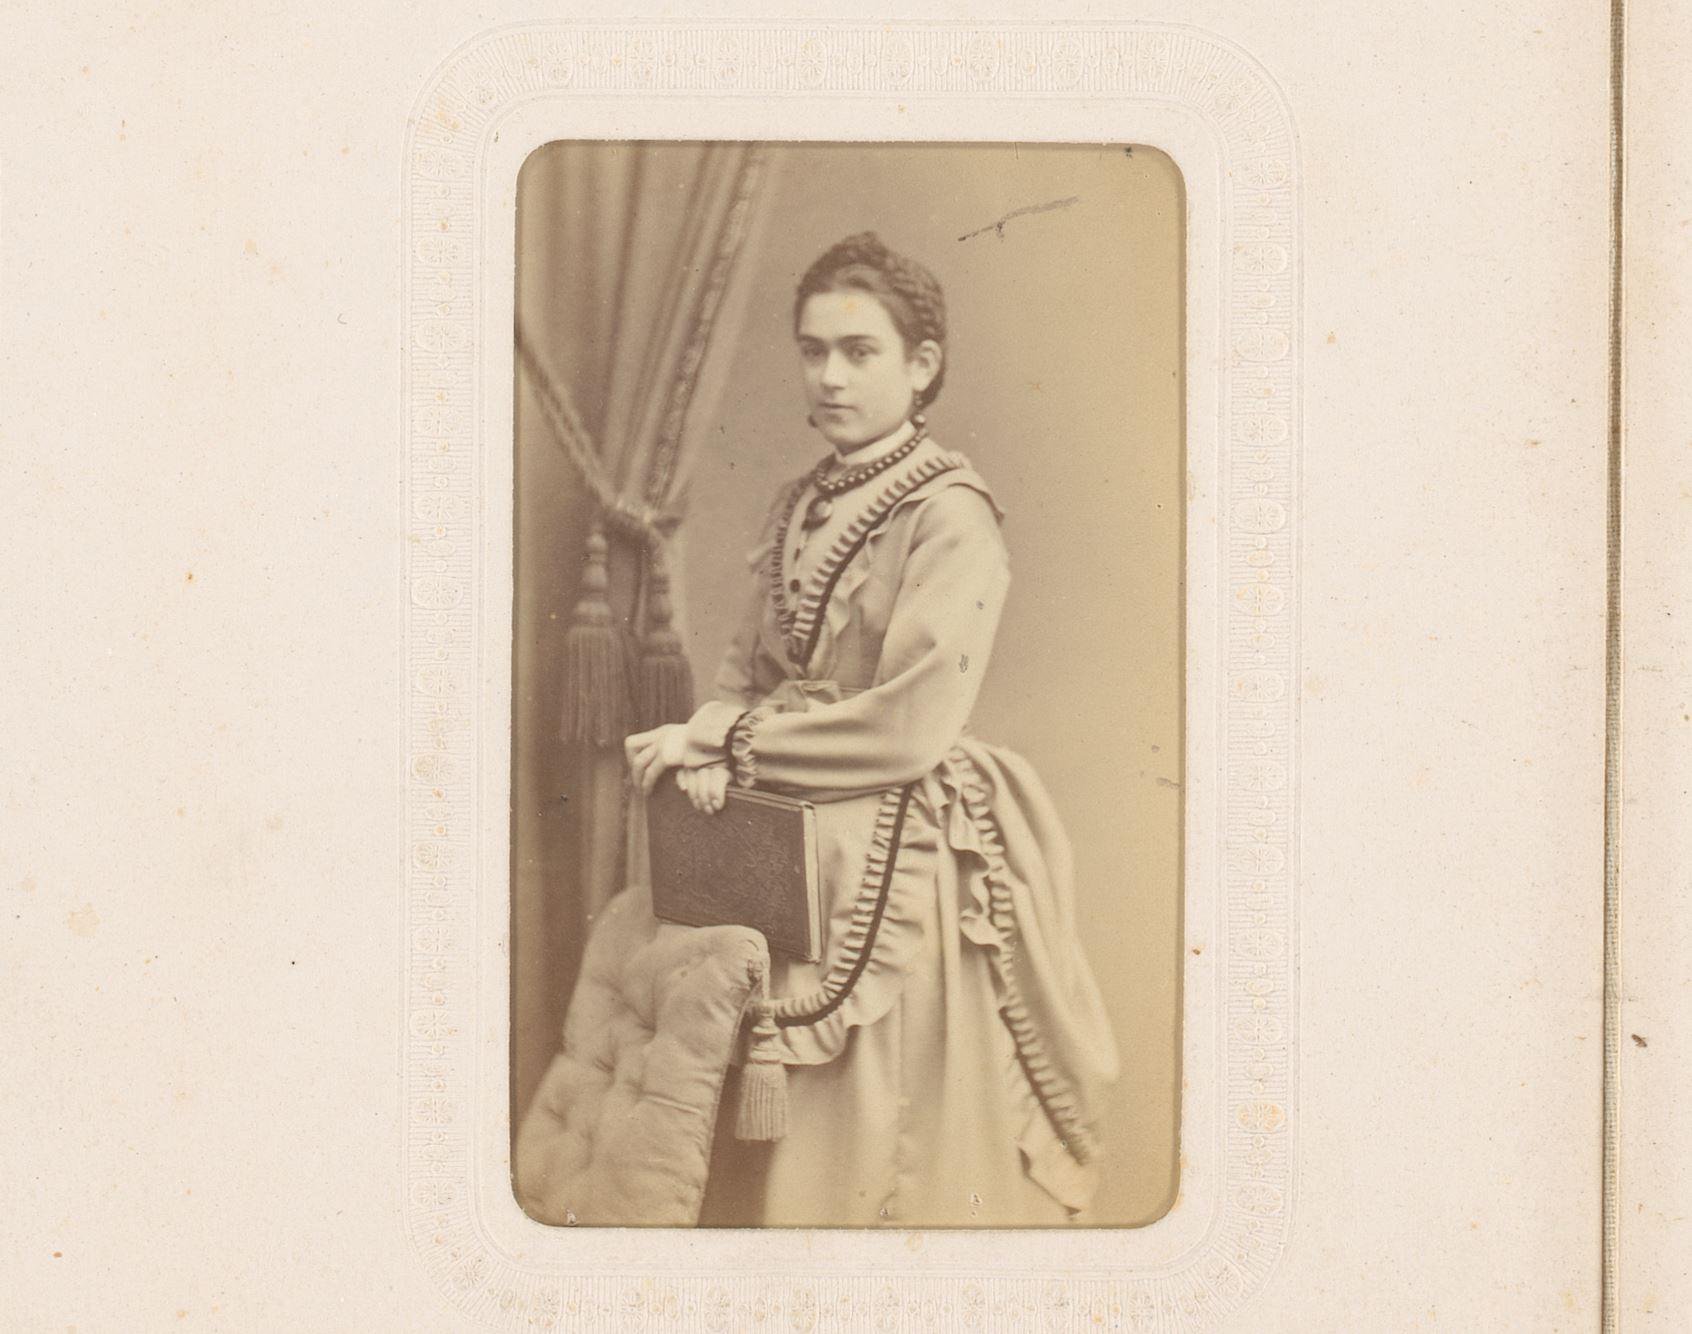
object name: album leaf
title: Portret van een vrouw met boek in de hand, staand bij een stoel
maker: Anonymous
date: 1860-1900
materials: cardboard, photographic support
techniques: albumen print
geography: netherlands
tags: historical persons - bb - woman, book, standing figure - aa - female human figure, chair